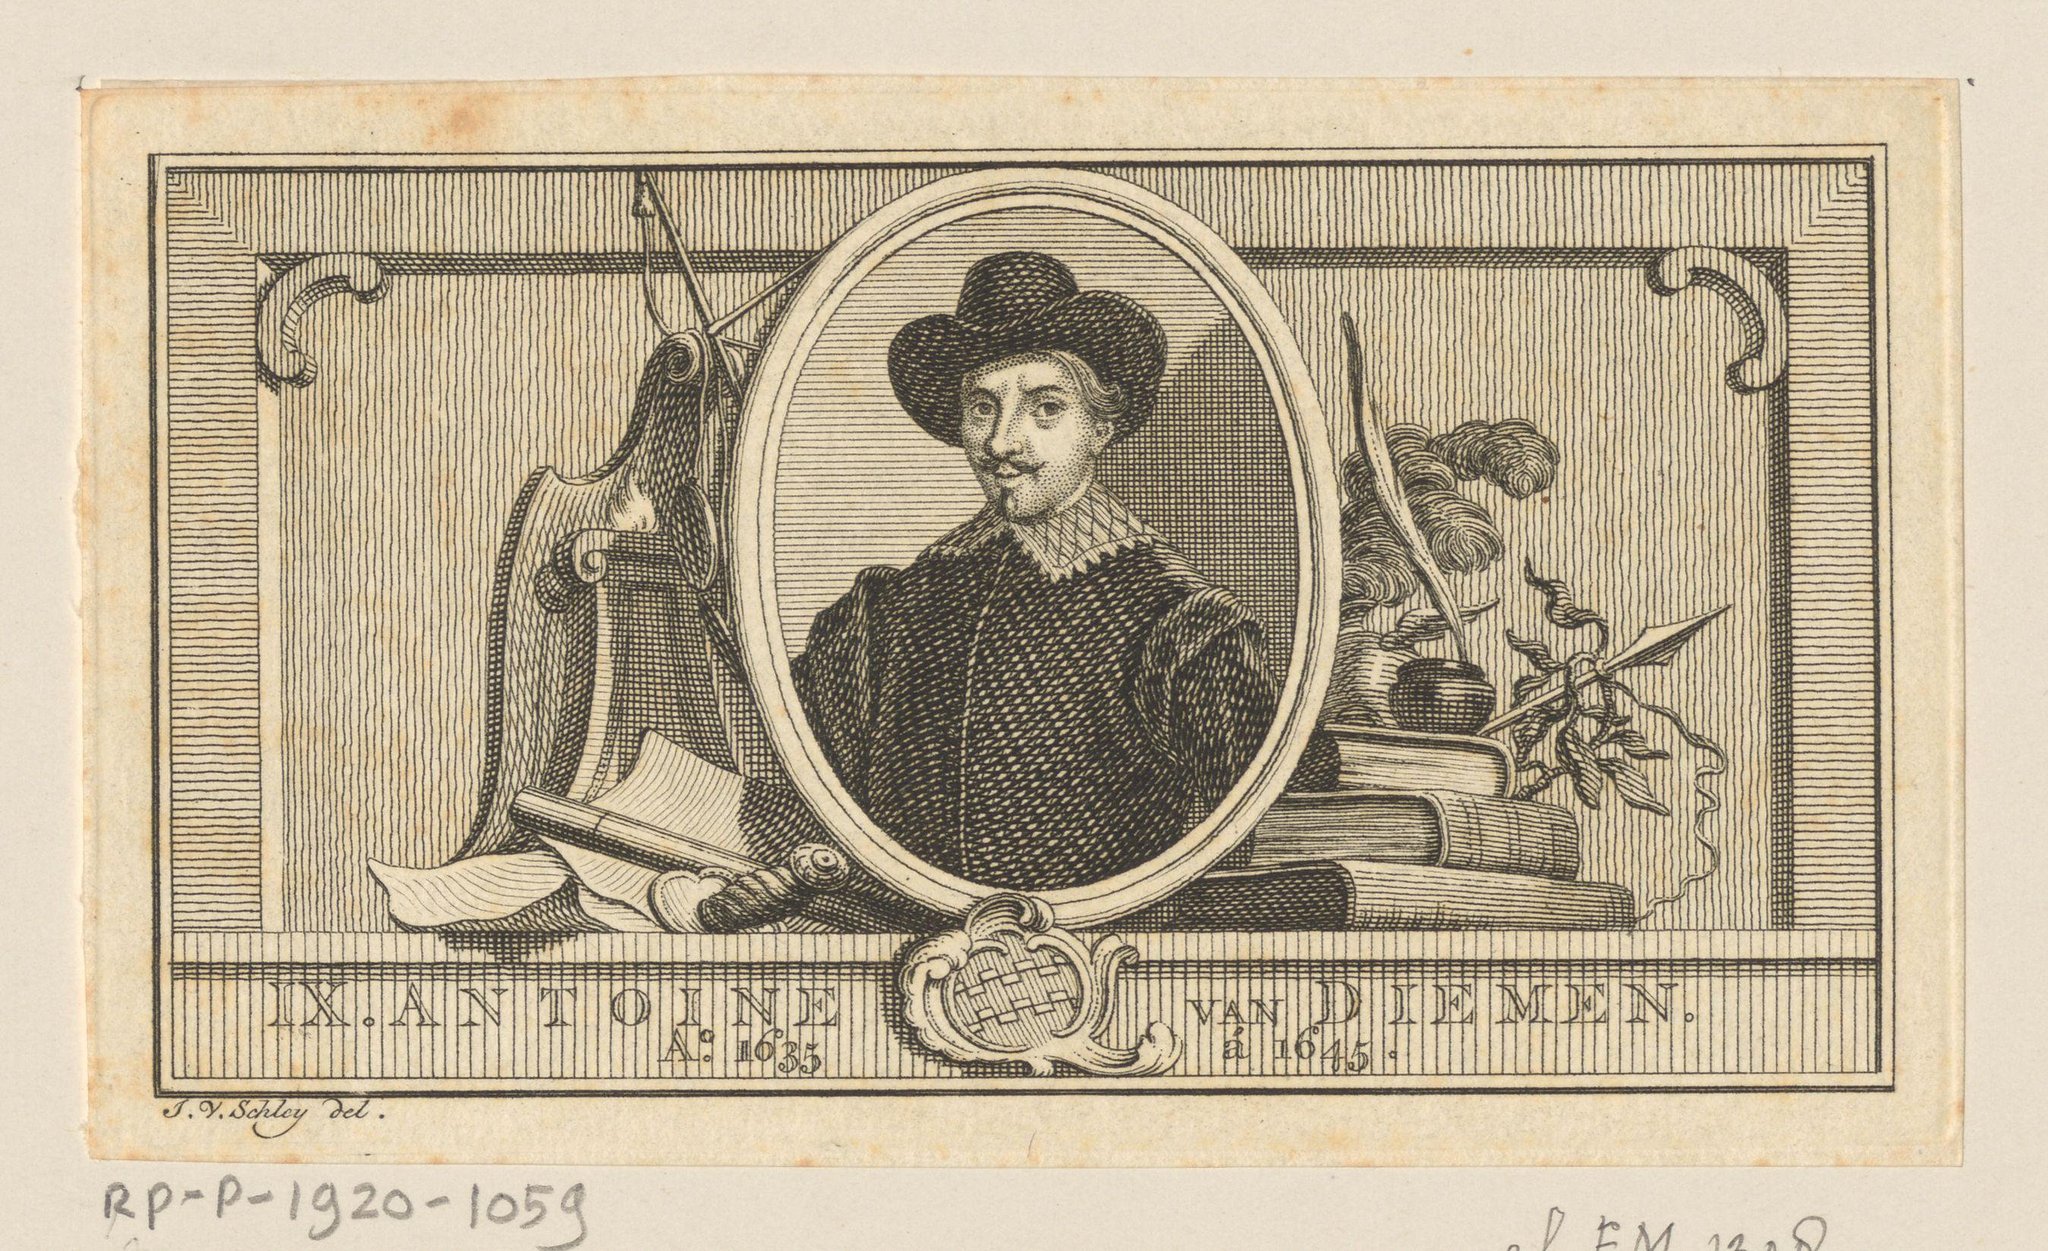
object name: print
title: Portret van Antonio van Diemen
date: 1763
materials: paper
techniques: engraving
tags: colonial governor, historical persons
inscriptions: collector's mark: Lugt 2228, collector's mark: Lugt 964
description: Prent met tekst op verso gebruikt in: Bois, J.P.J. du. Vies des gouverneurs generaux, avec l'abrege de l'histoire des etablissemens Hollandois aux Indes orientales. Den Haag: Pieter de Hondt, 1763, dl. 17.